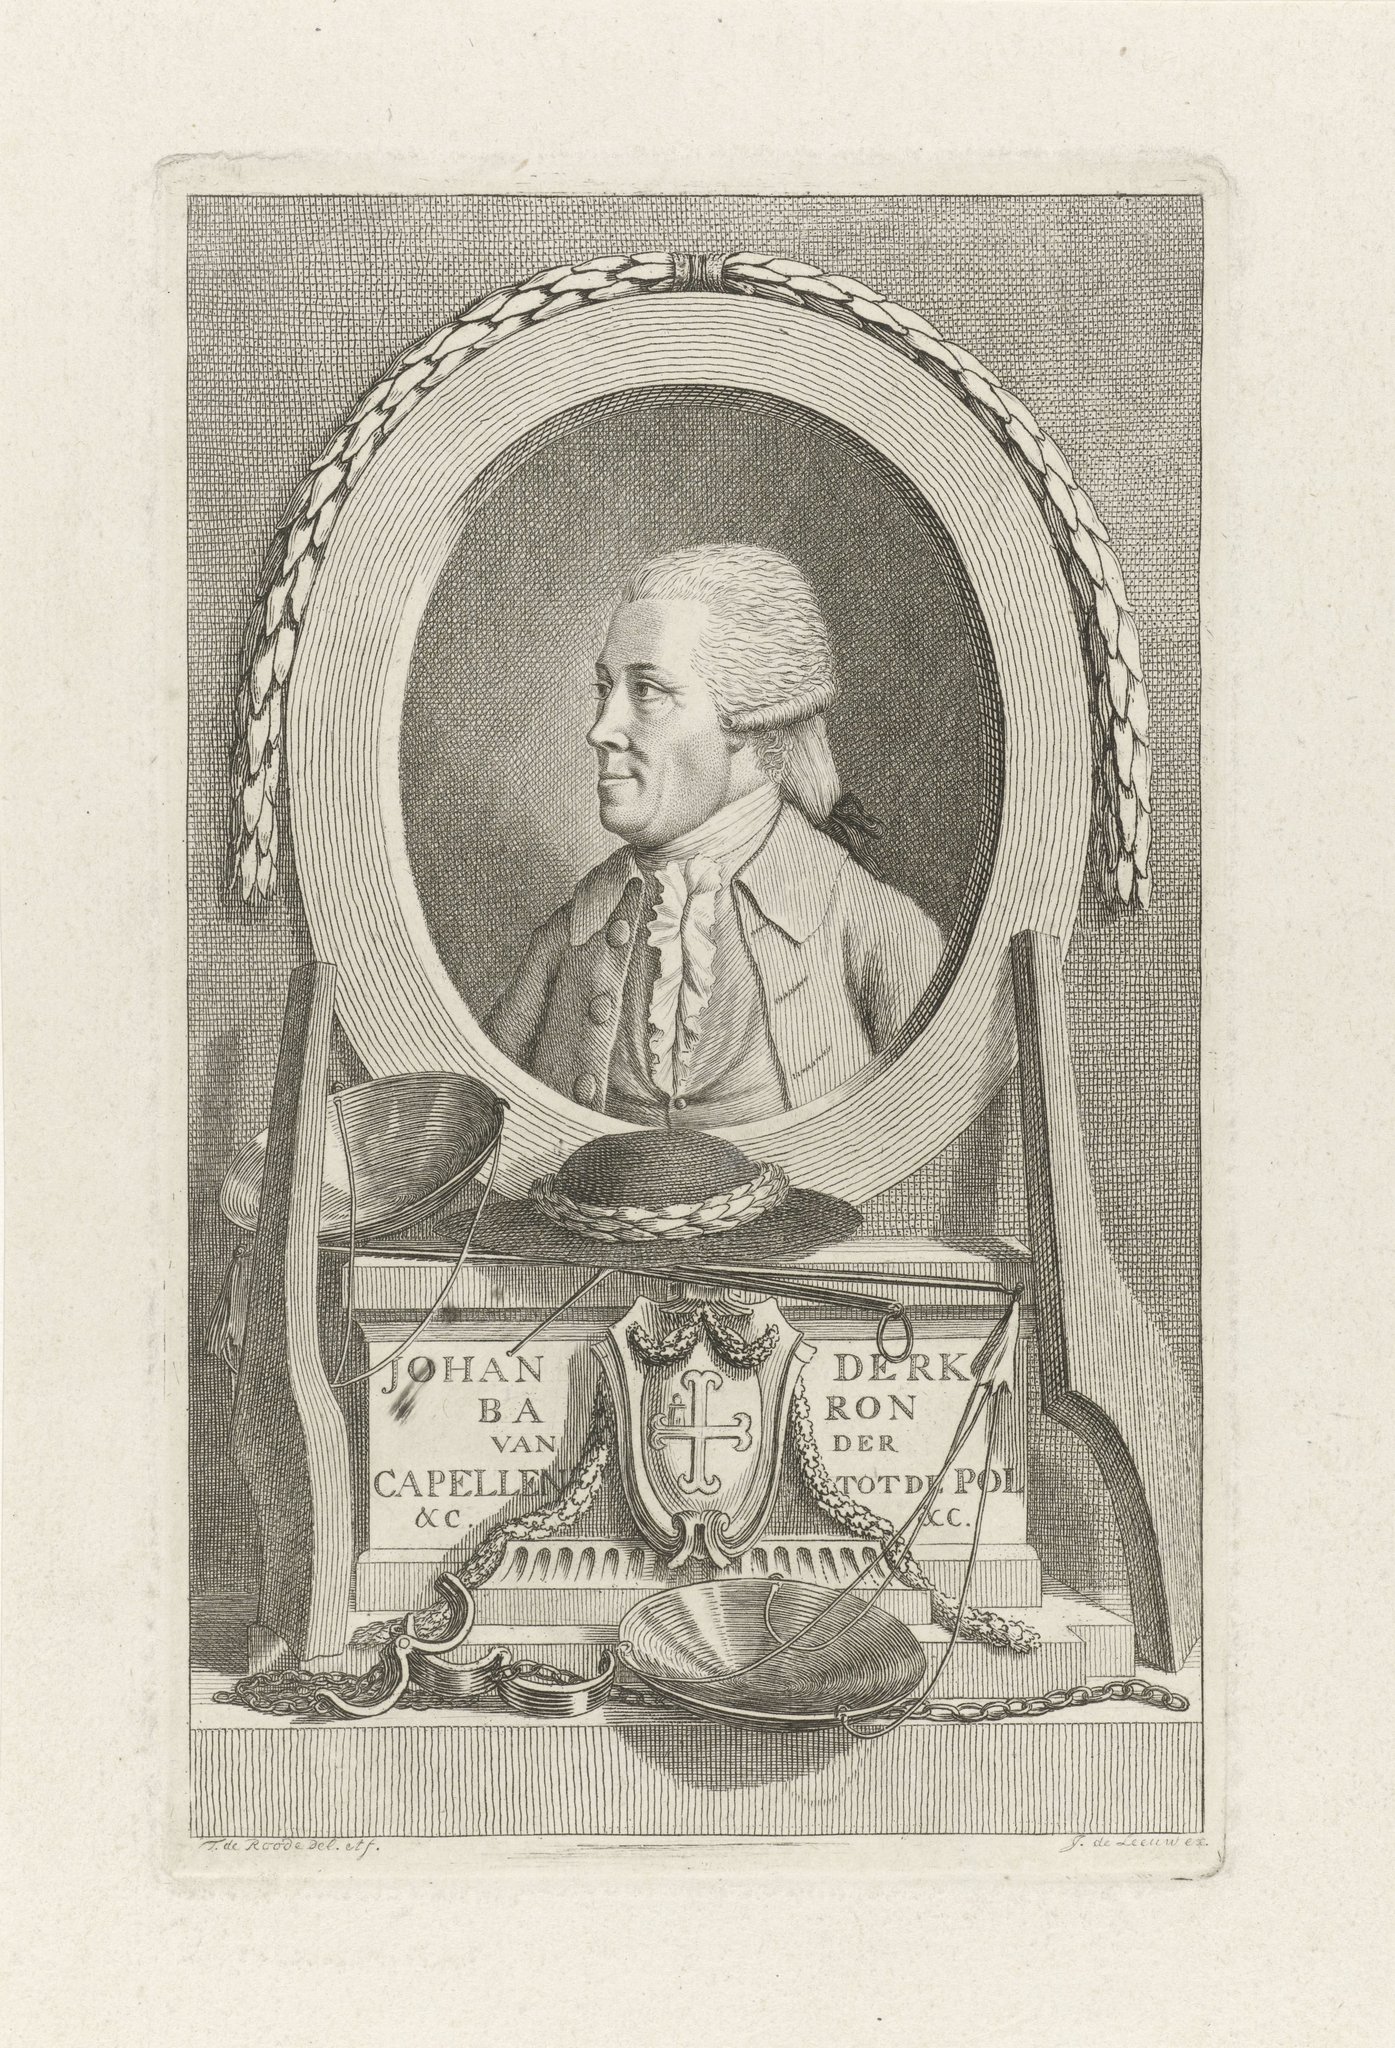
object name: print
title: Portret van Joan Derk van der Capellen tot den Pol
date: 1774-1797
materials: paper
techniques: engraving, etching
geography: netherlands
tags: joan derk van der capellen tot den pol, scales, handcuffs, freedom, liberty; 'libertà' (ripa) (+ symbolical representation of concept)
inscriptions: collector's mark: Lugt 2228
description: Portret van Joan Derk, baron van der Capellen tot den Pol. Hij speelde een belangrijke rol in de patriottenbeweging en schreef in 1781 het anoniem verschenen pamflet 'Aan het volk van Nederland' (1781). Onder zijn portret een weegschaal, boeien en de vrijheidshoed.